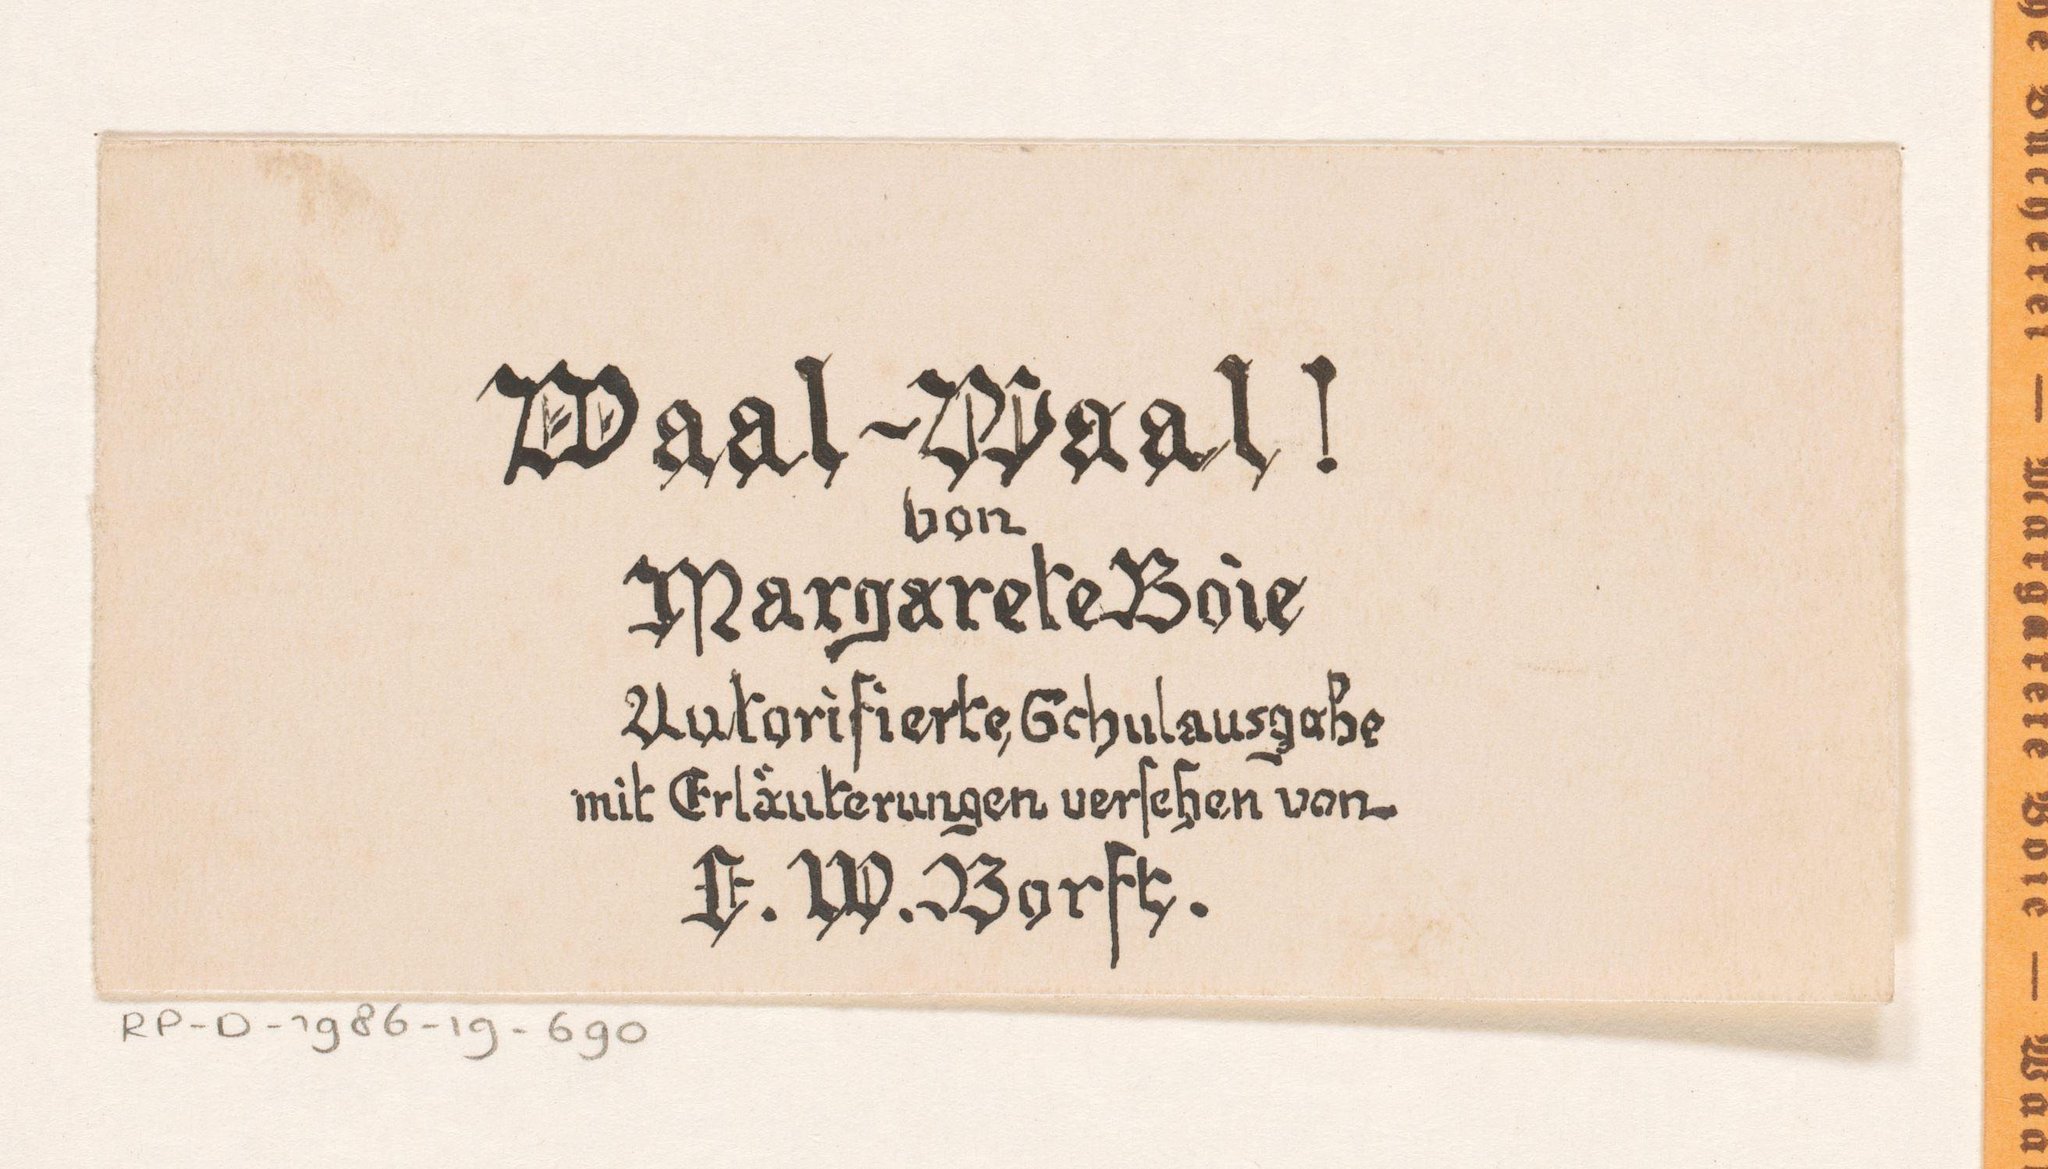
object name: drawing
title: Letterontwerp voor: Margarete Boie, Waal - Waal! Das leben eines Sylter Grönlandfährers, 1942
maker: reinier willem petrus de vries (1874-1953)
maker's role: draughtsman, print maker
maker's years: 1874-1953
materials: ink, paper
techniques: pen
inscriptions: collector's mark: ‘R:MVS.’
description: Bandontwerp voor: Boie, Margarete. Waal - Waal! Das leben eines Sylter Grönlandfährers. Zutphen: W.J. Thieme & Cie (schulausgabe mit Erläuteringen versehen von F.W. Borst) 1942.